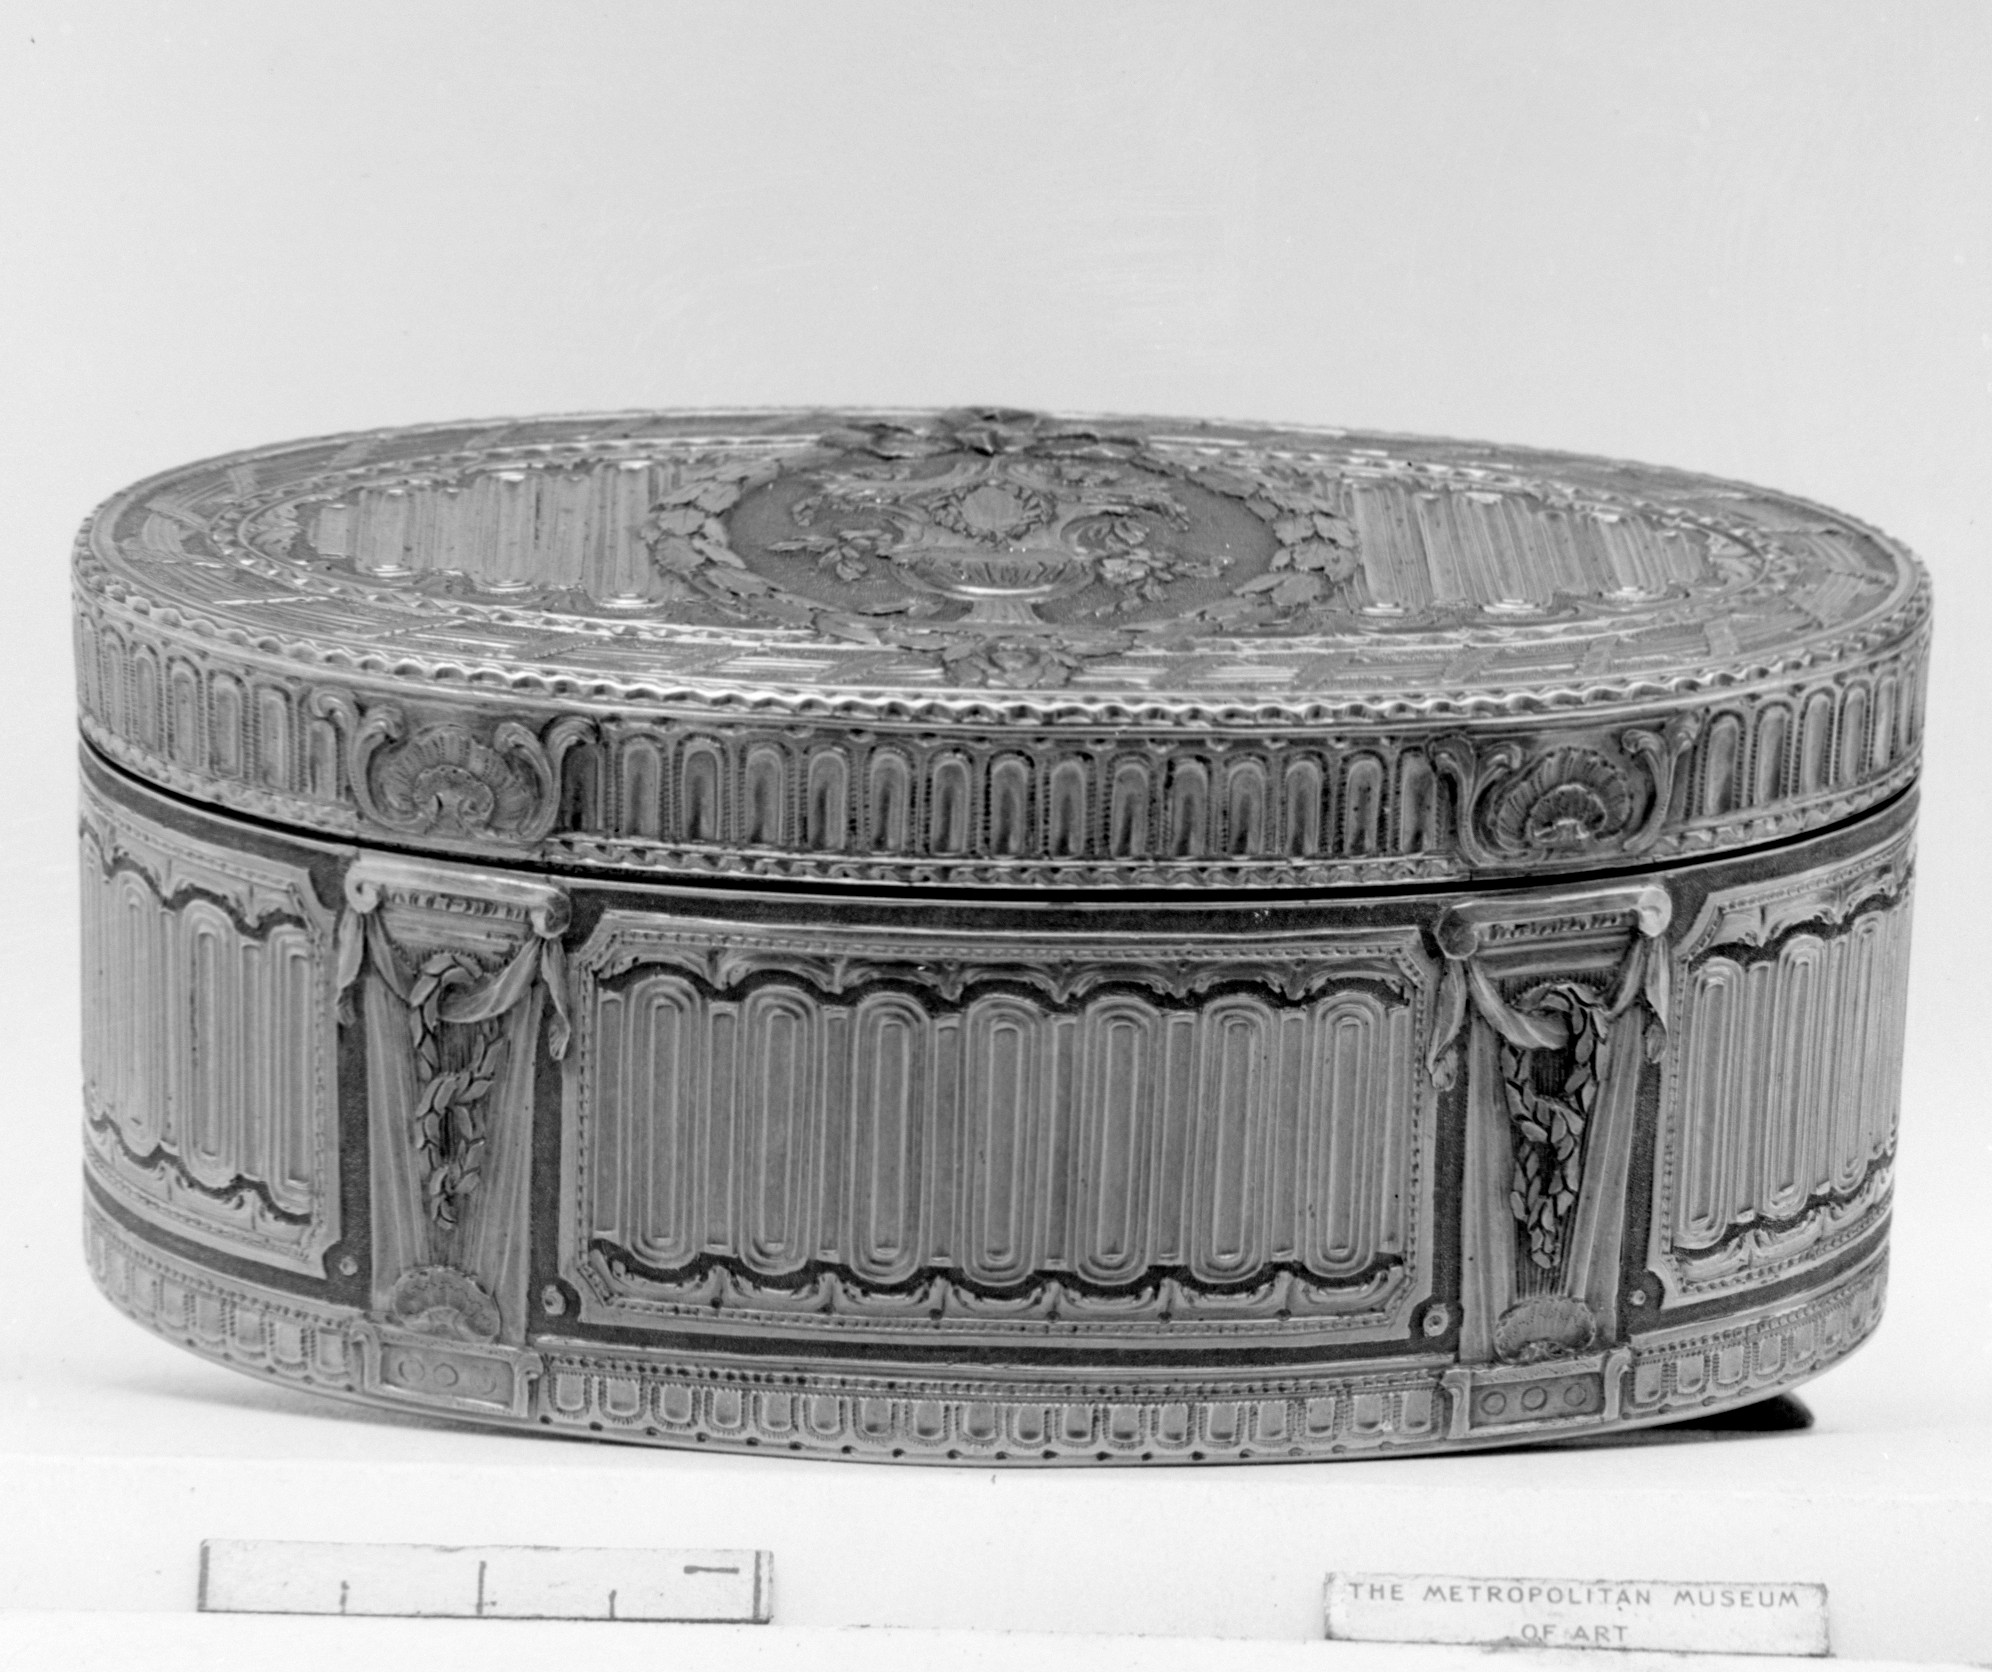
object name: snuffbox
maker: jean frémin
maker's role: maker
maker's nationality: french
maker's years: 1738-1786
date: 1763-1764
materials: gold